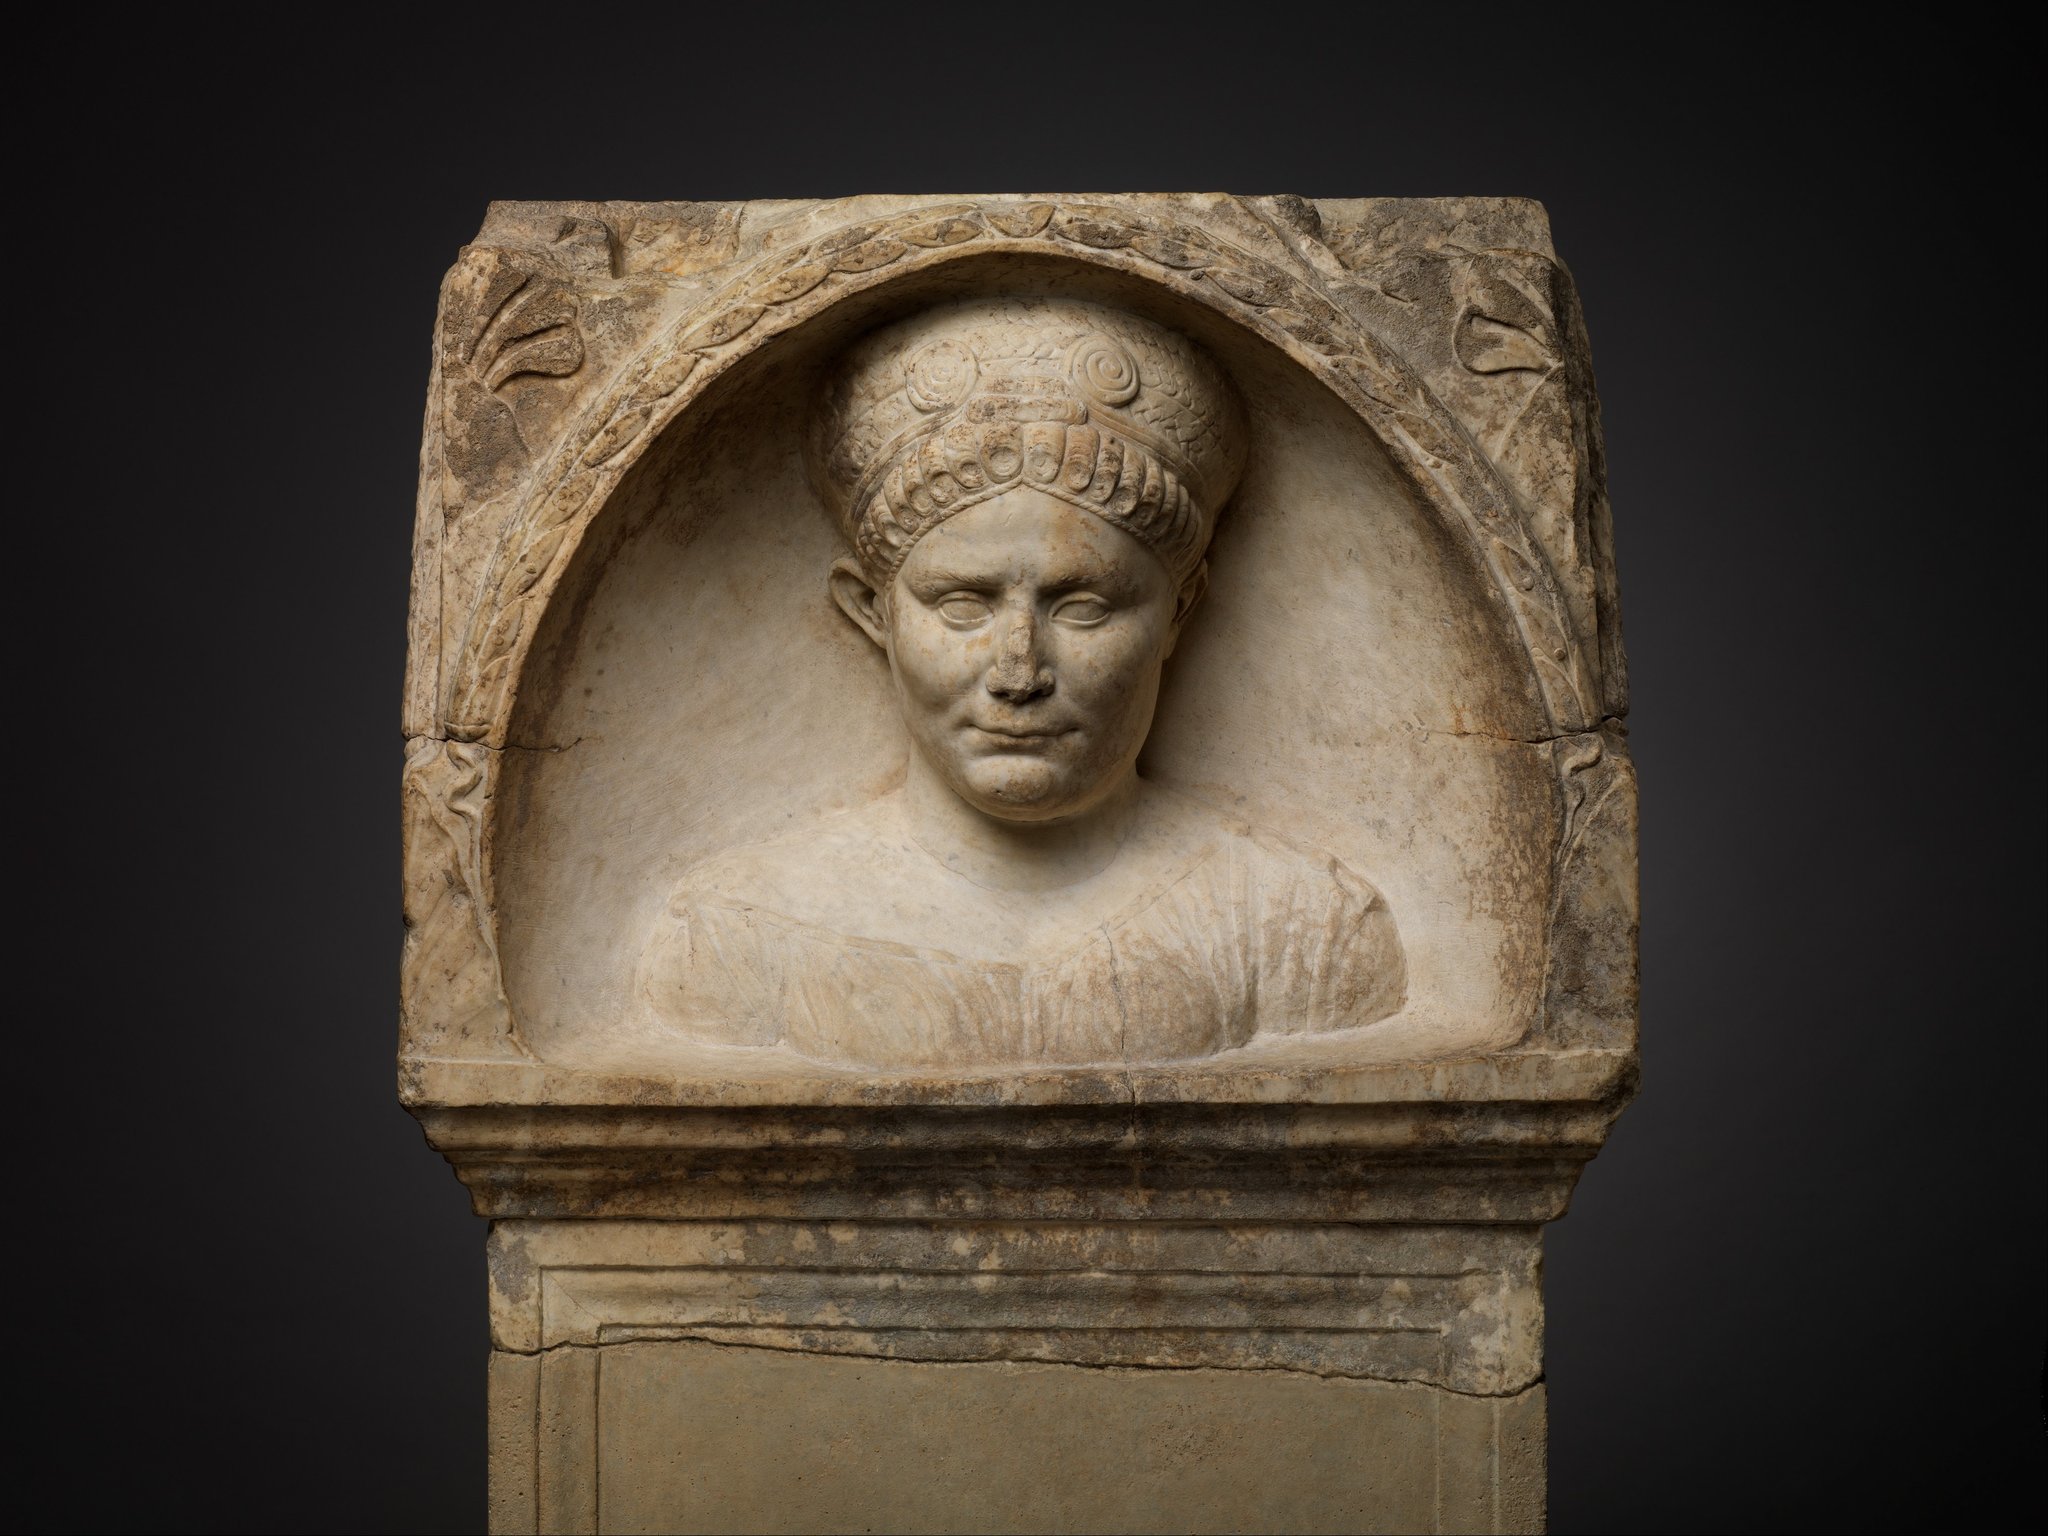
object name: cippus upper part with three portrait head in relief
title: Marble pediment of a funerary altar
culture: roman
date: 120-130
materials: marble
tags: portraits,women